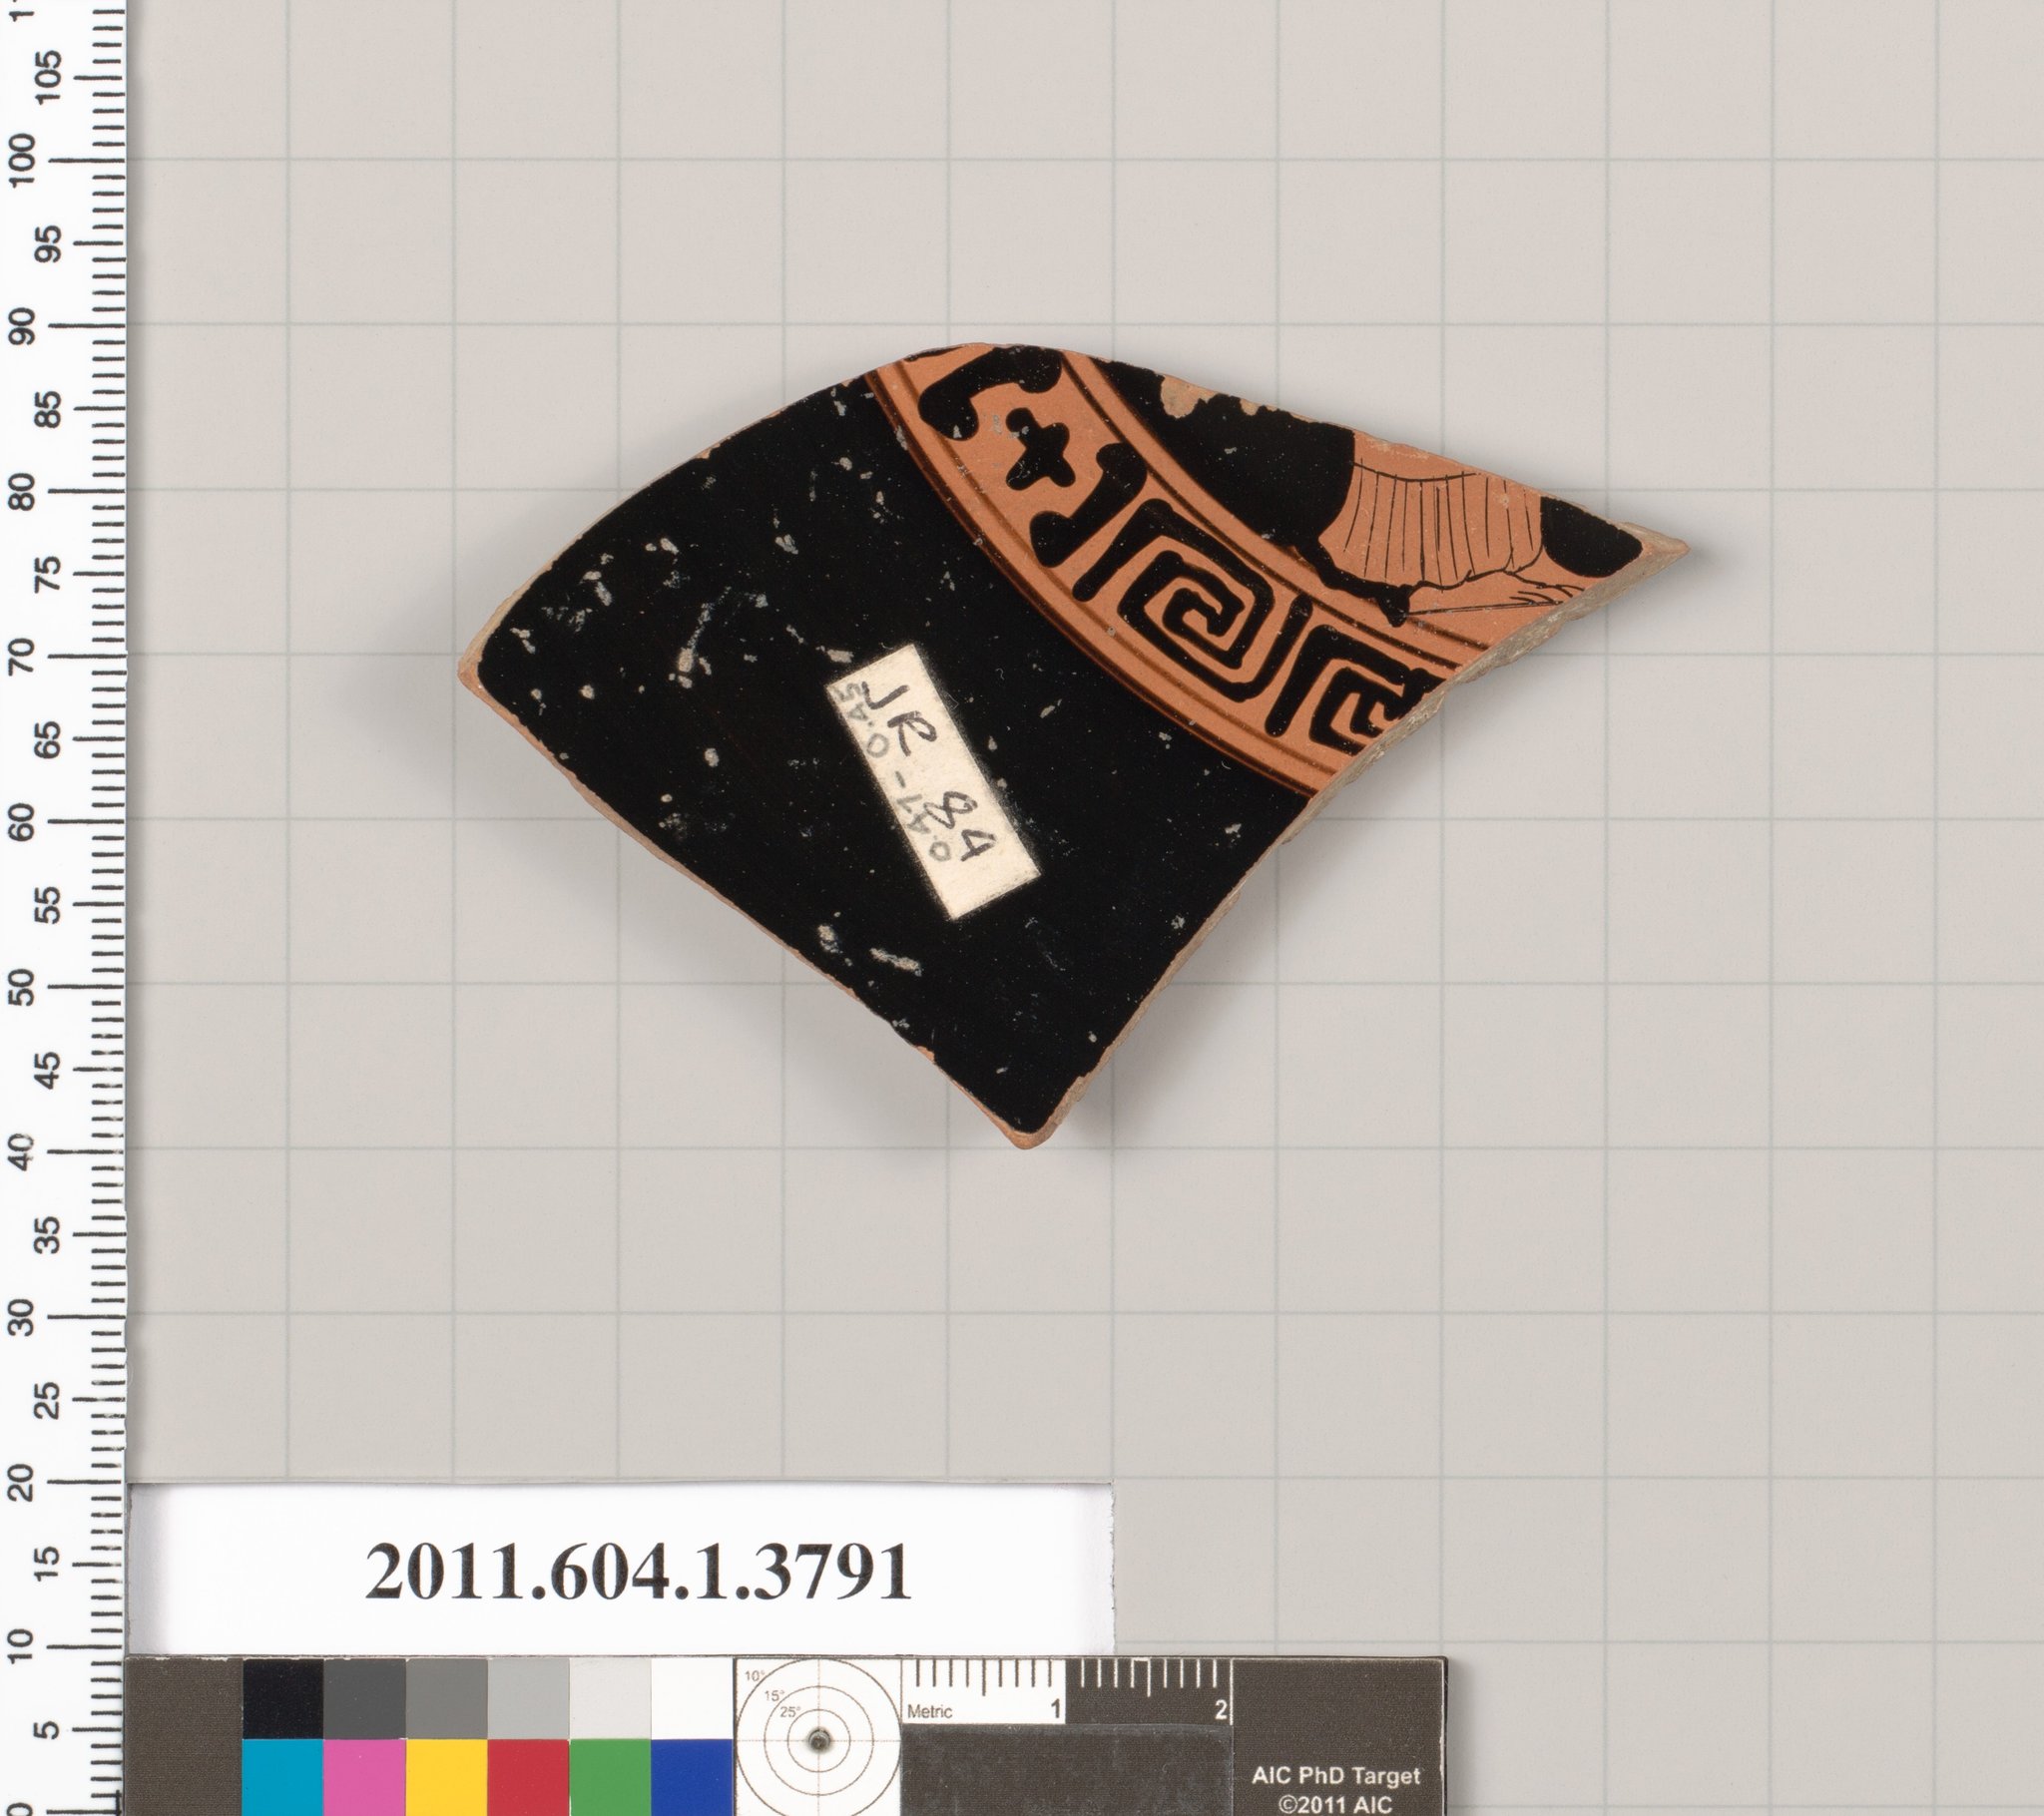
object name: kylix fragment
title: Terracotta fragment of a kylix (drinking cup)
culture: greek, attic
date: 475-451 BCE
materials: terracotta